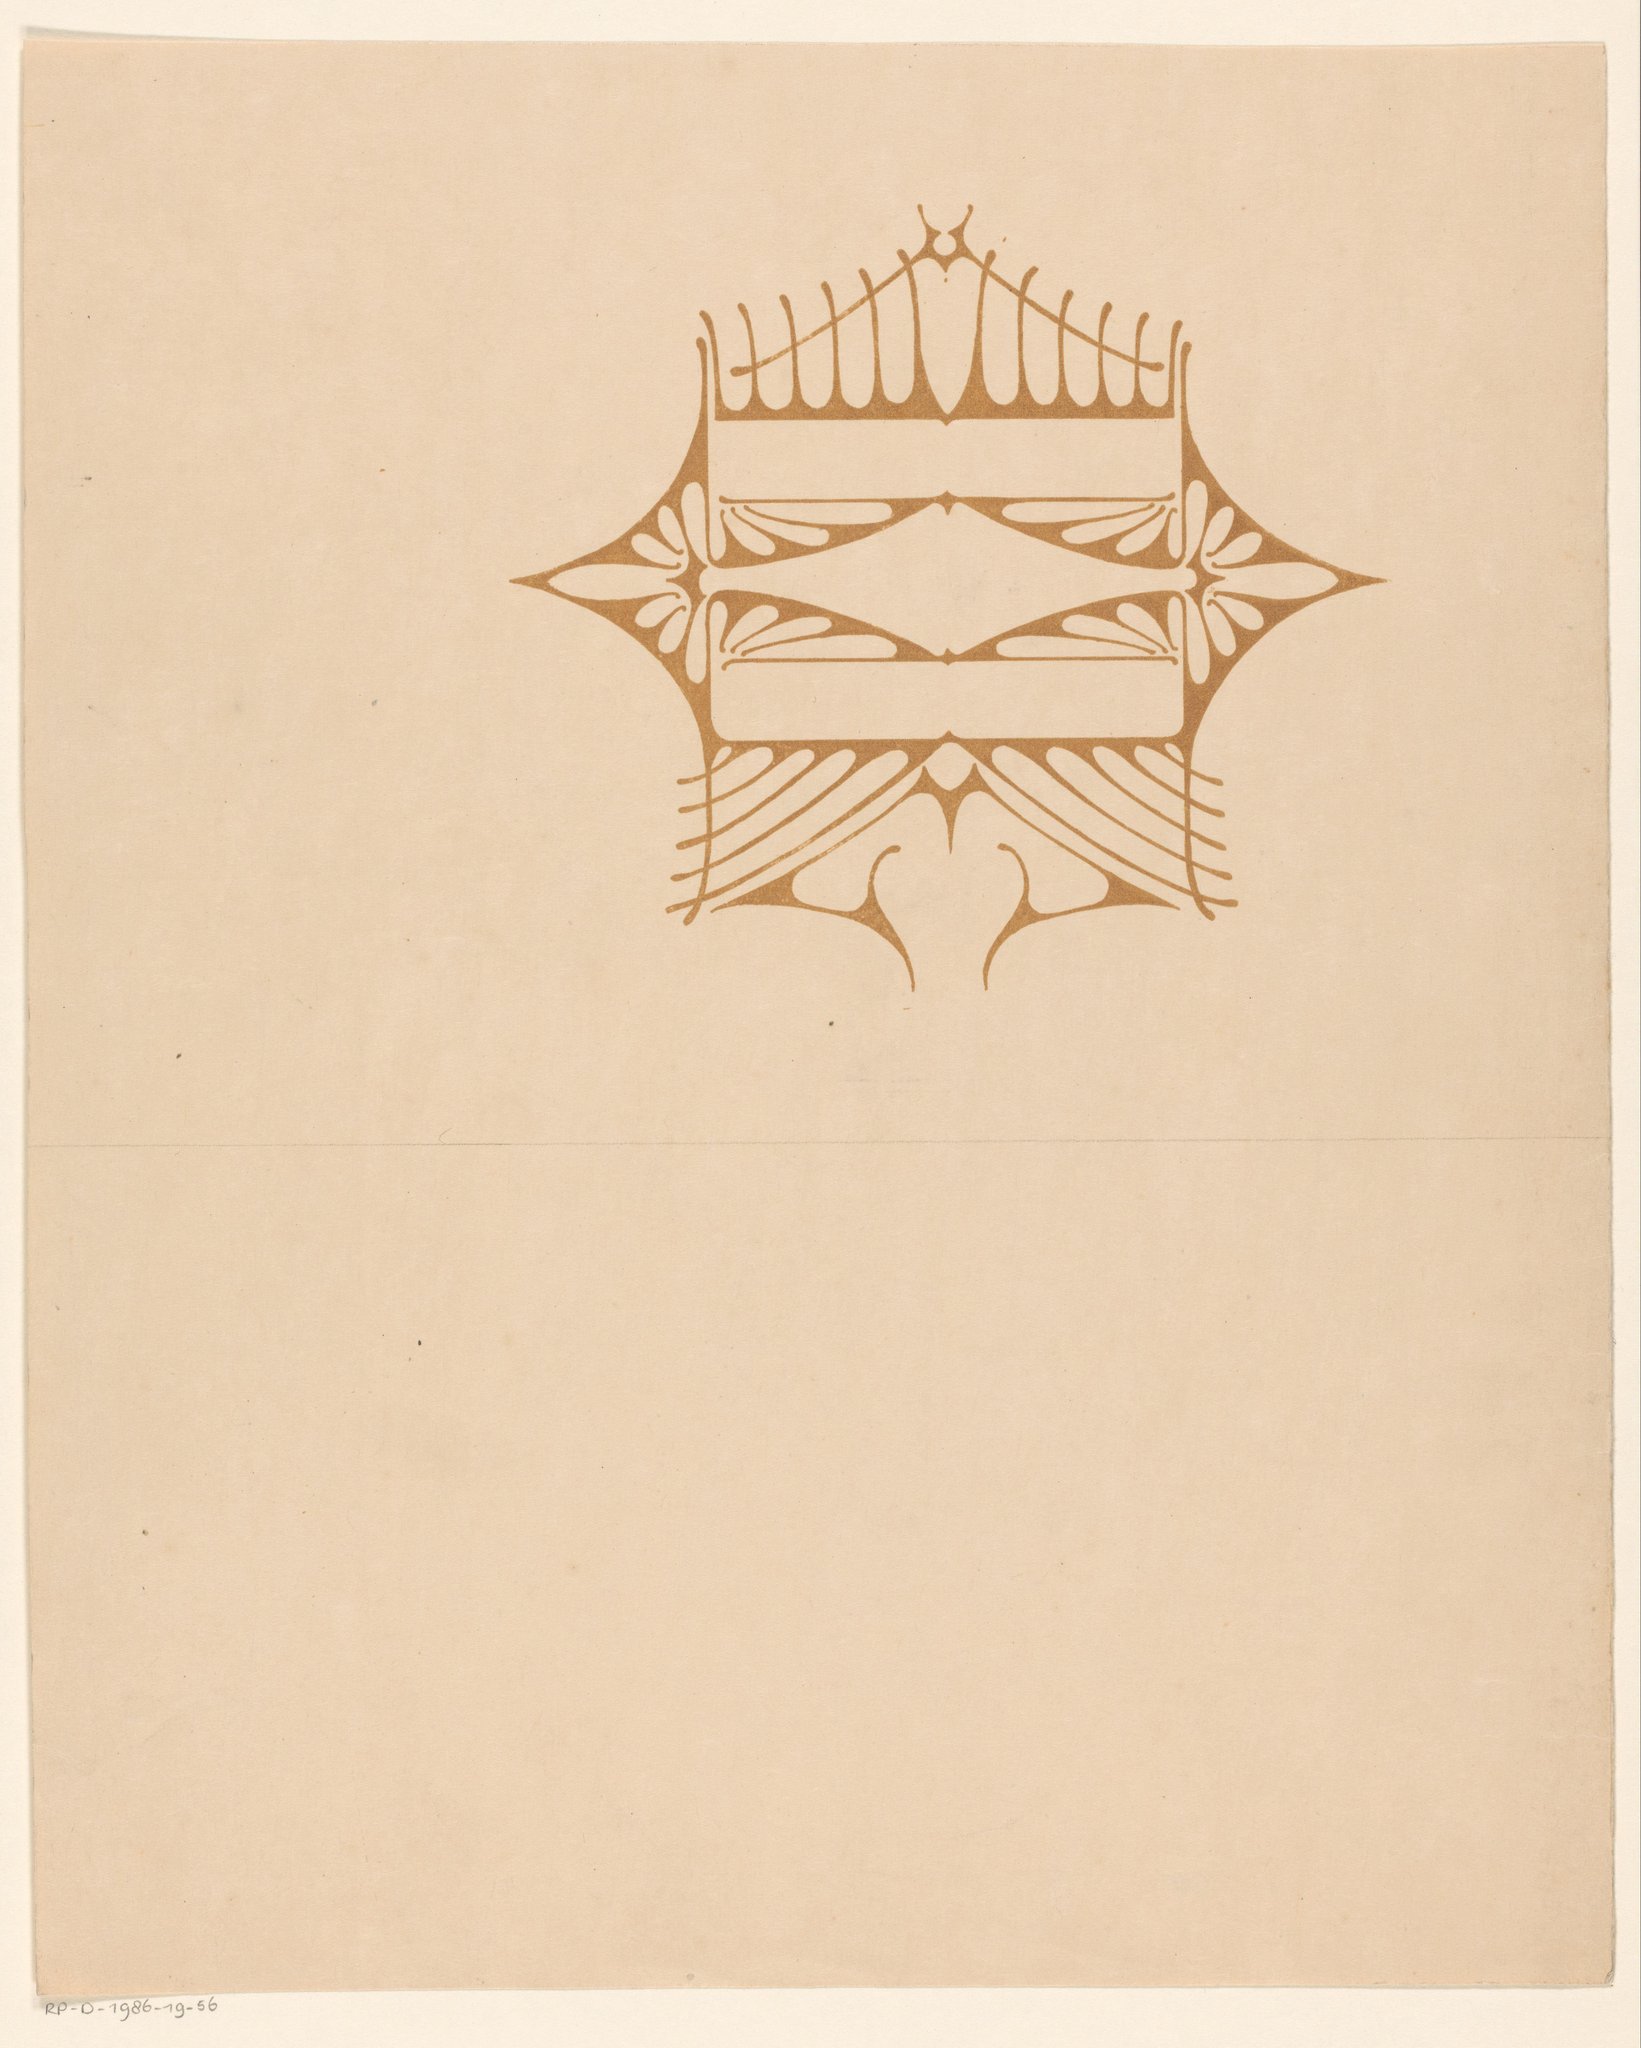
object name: design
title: Titelkader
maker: reinier willem petrus de vries (1874-1953)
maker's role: draughtsman, print maker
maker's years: 1874-1953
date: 1884-1952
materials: paper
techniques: relief print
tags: flowers ~ ornament - aa - stylized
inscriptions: collector's mark: ‘R:MVS.’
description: Ontwerp voor een datumblad voor een album voor Dr. H.C. Rogge, hoogleraar geschiedenis aan de Universiteit van Amsterdam, ter gelegenheid van zijn 25-jarig eredoctoraat aan de Leidse Hogeschool.